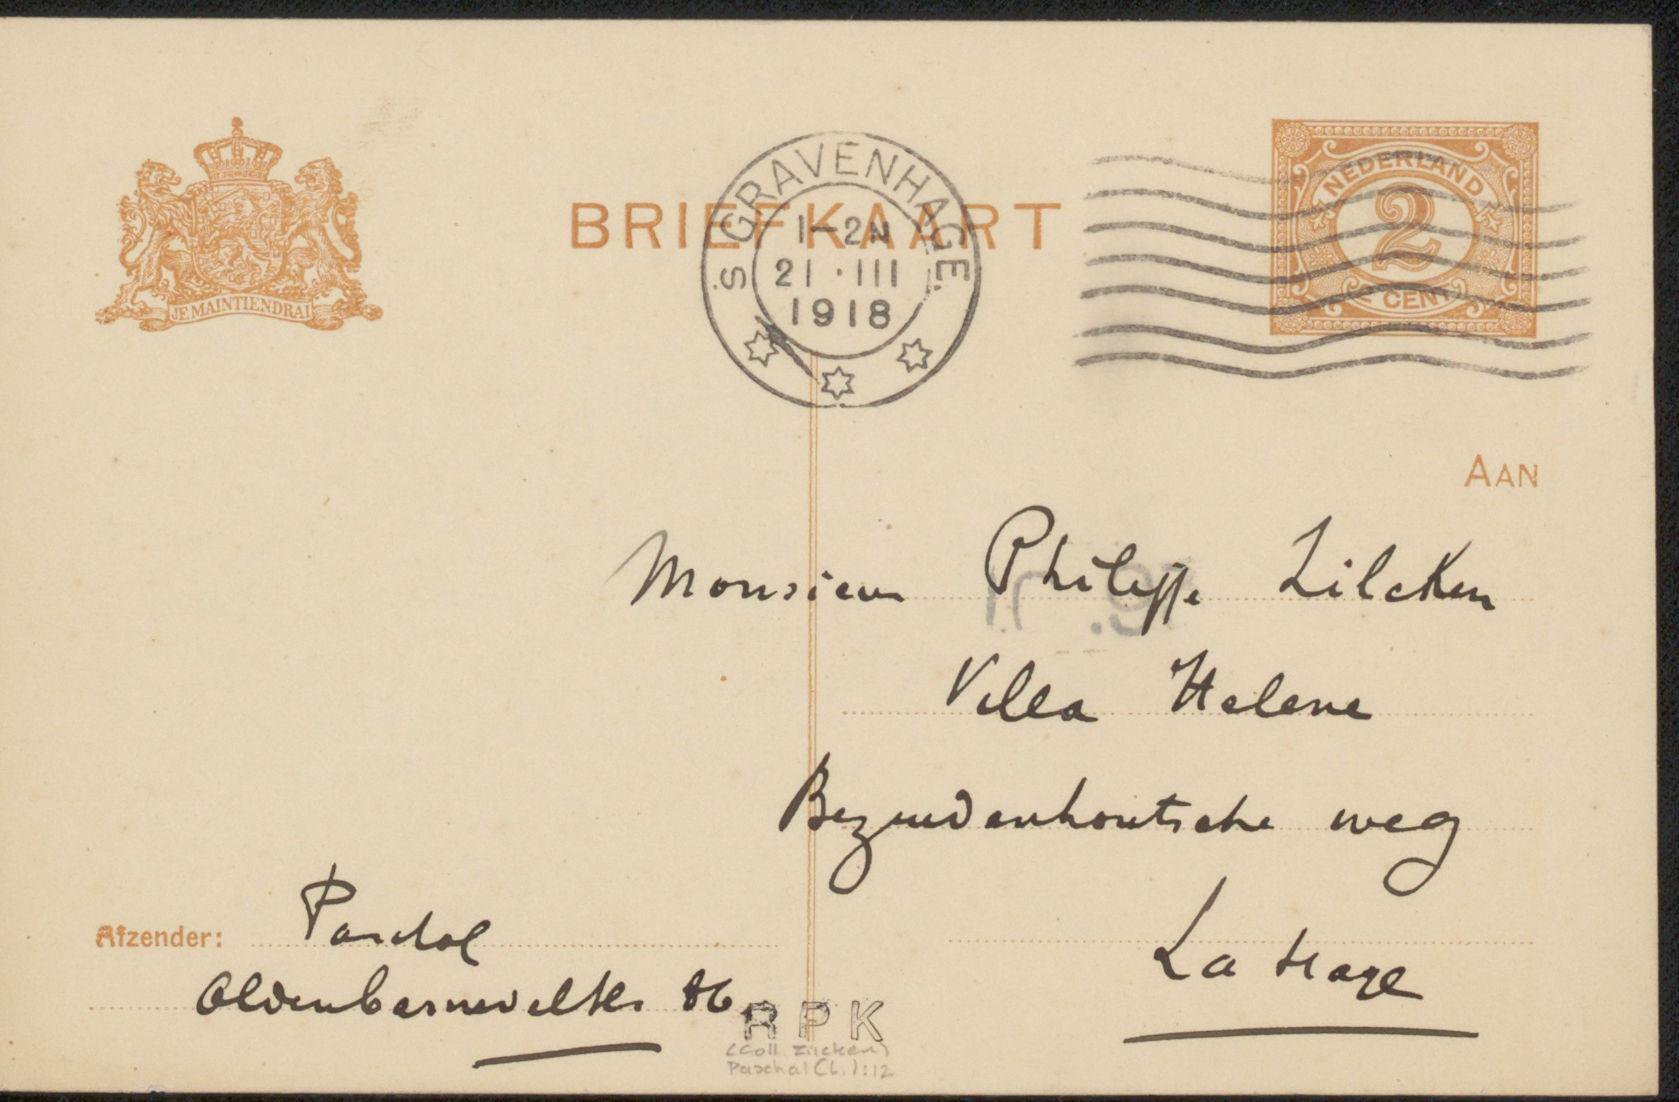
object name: postcard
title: Briefkaart aan Philip Zilcken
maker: léon paschal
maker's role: schrijver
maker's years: 1873-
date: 1918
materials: cardboard, ink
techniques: pen, writing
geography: the hague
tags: the hague, painter, draughtsman, philip zilcken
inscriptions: collector's mark: ‘RPK’